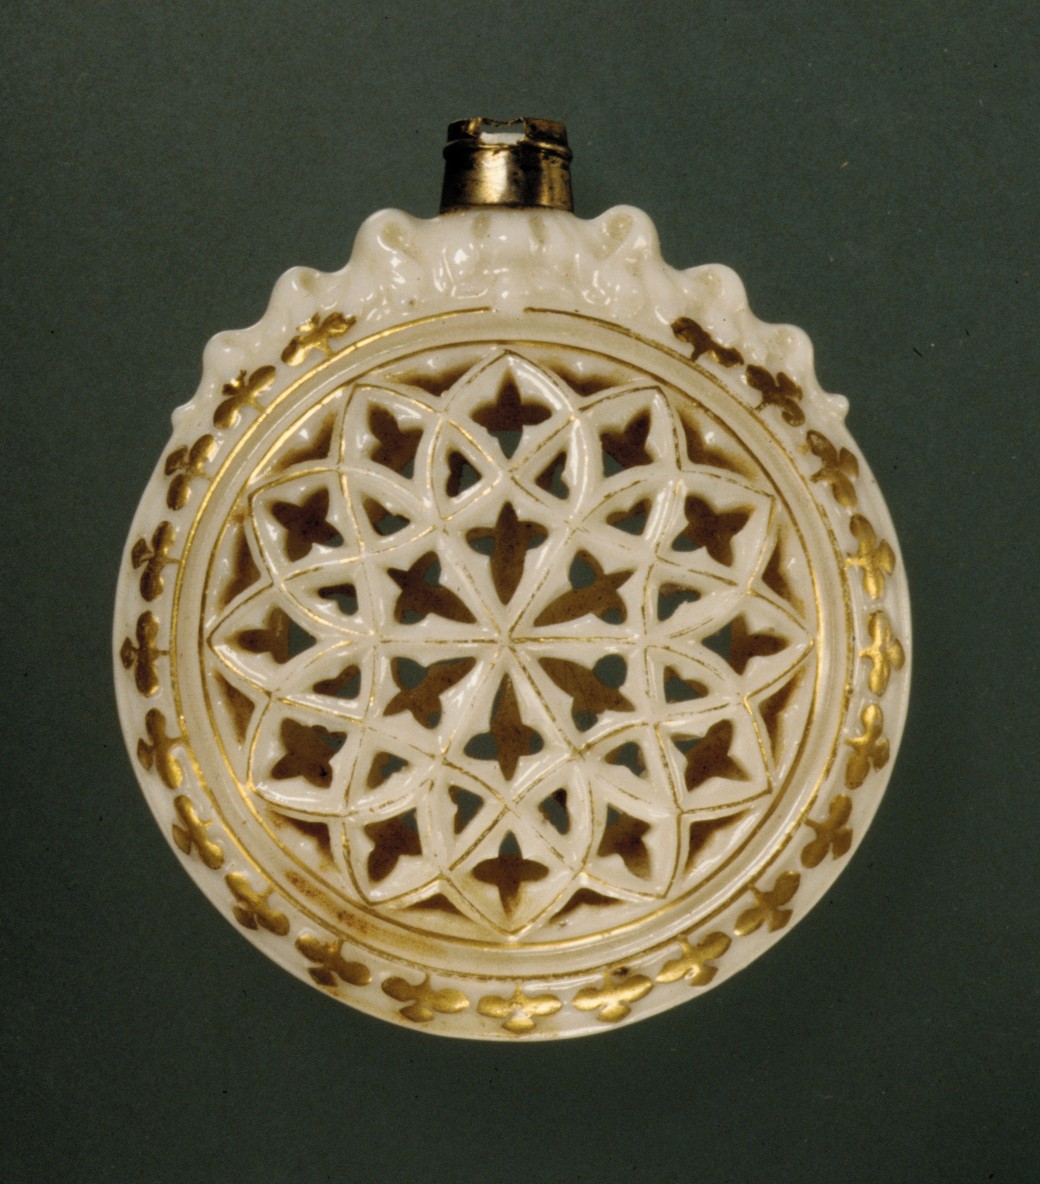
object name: perfume flask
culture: american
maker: willets manufacturing company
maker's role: maker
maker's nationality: american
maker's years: 1879-1908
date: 1883-1887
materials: porcelain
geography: united states